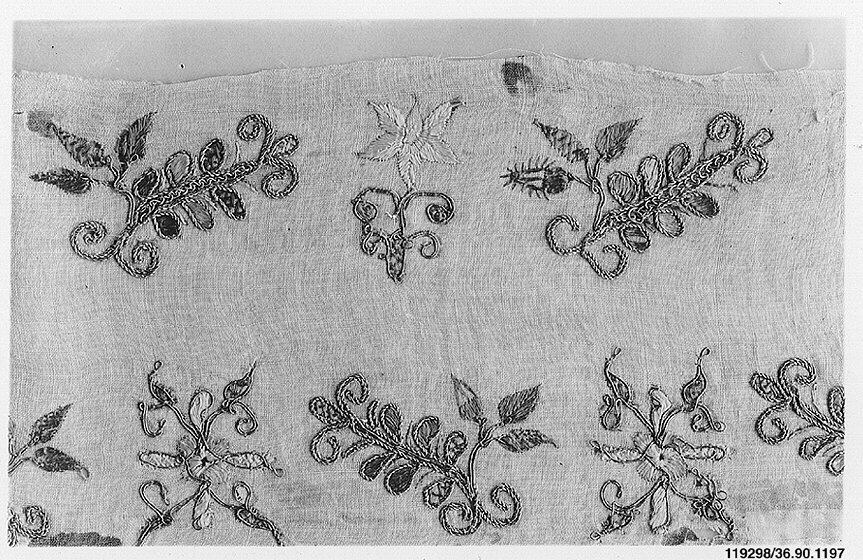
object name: piece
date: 1501-1600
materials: cotton, silk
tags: flowers